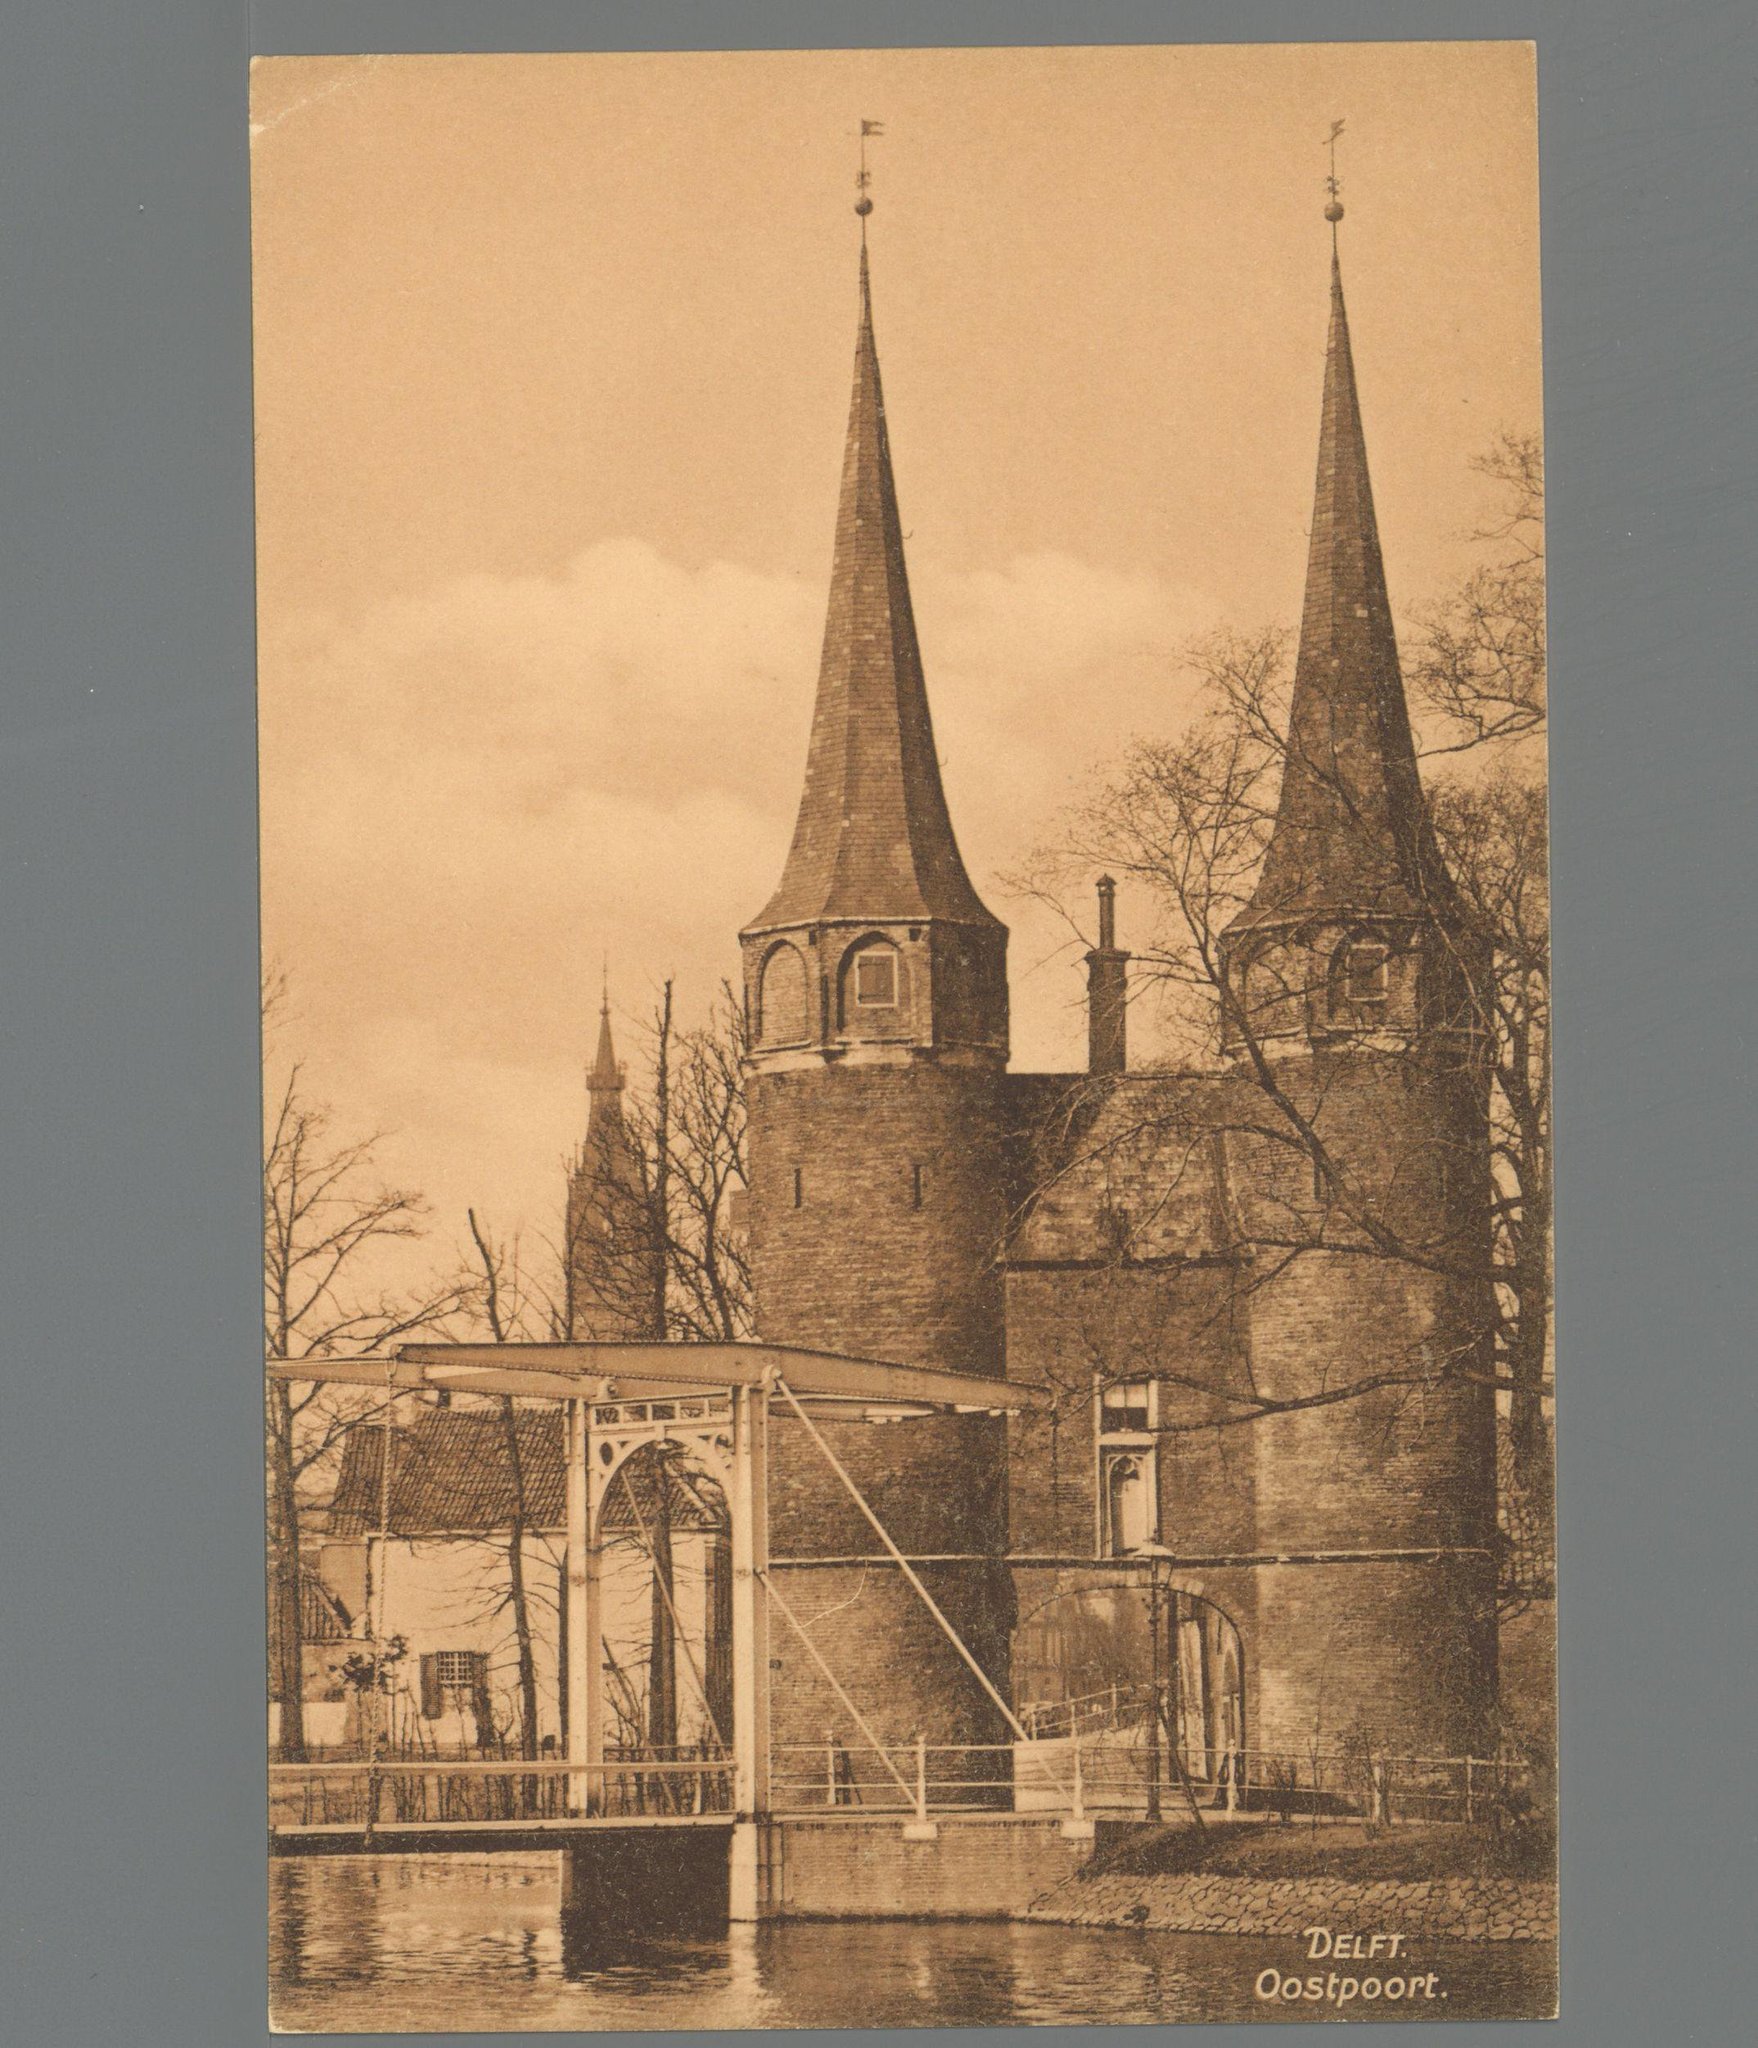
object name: ansichtkaart, prentbriefkaart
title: Delft. Oostpoort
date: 1911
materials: cardboard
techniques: photograph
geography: delft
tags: church (exterior), bridge in city across river, canal, etc., city-gate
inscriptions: date